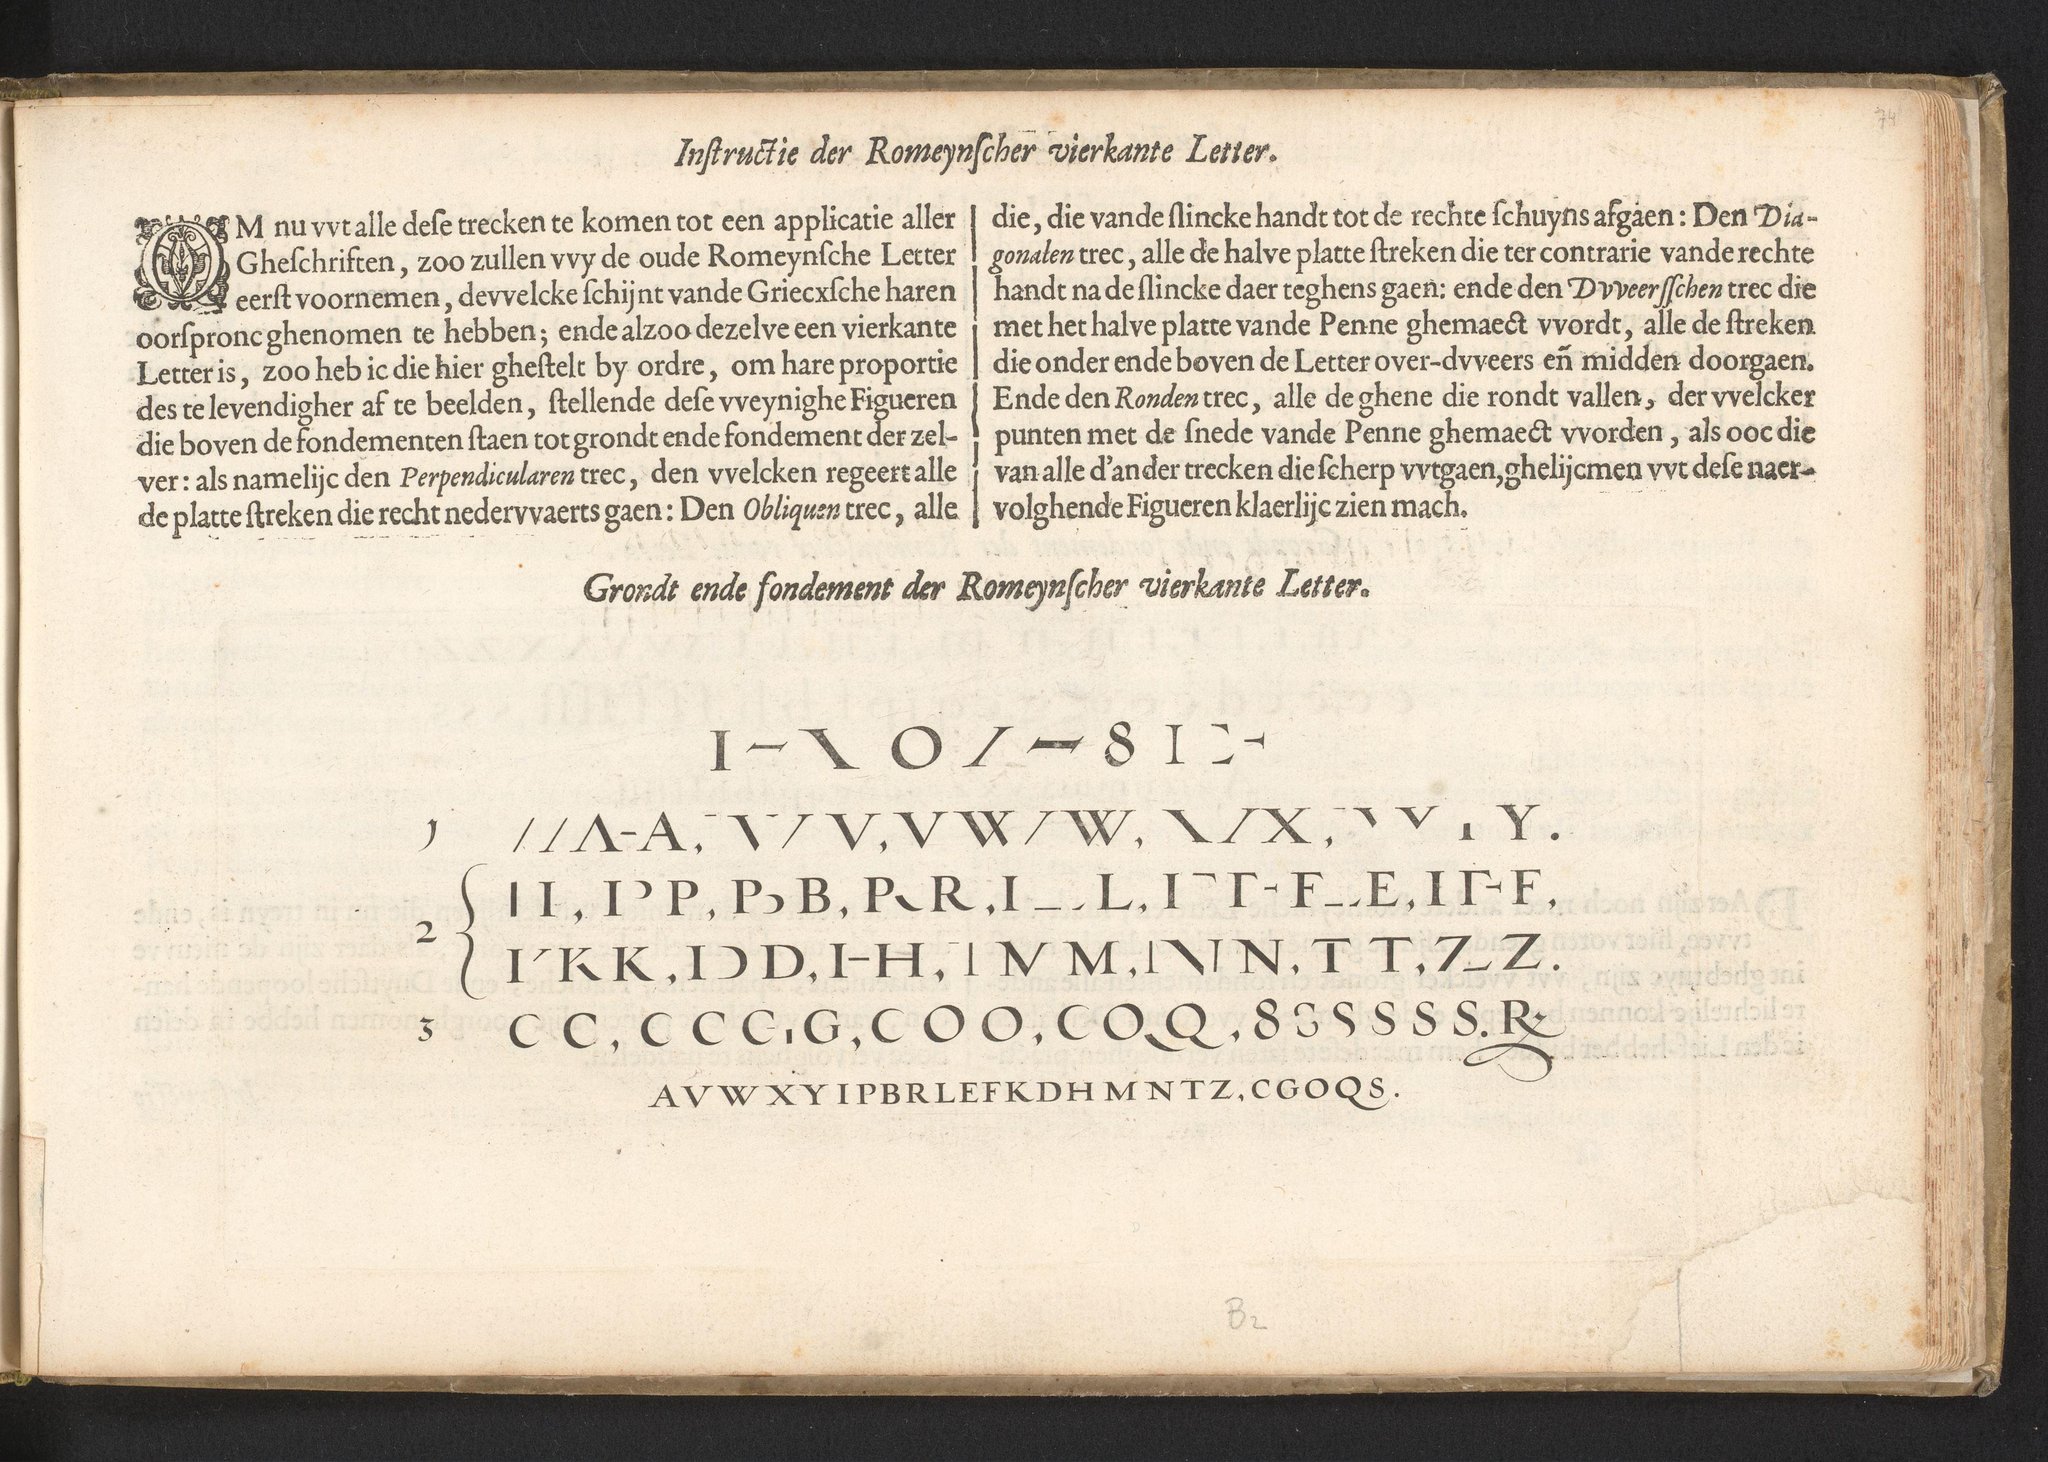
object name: print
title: Fondement-Boeck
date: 1605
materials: paper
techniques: engraving, letterpress printing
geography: rotterdam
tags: calligraphy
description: Folio B2r met een schrijfvoorbeeld getiteld: Grondt ende fondament der Romeynscher vierkante letter. De beschrijving vangt aan met een gedecoreerde initiaal O. Het blad maakt deel uit van een album.